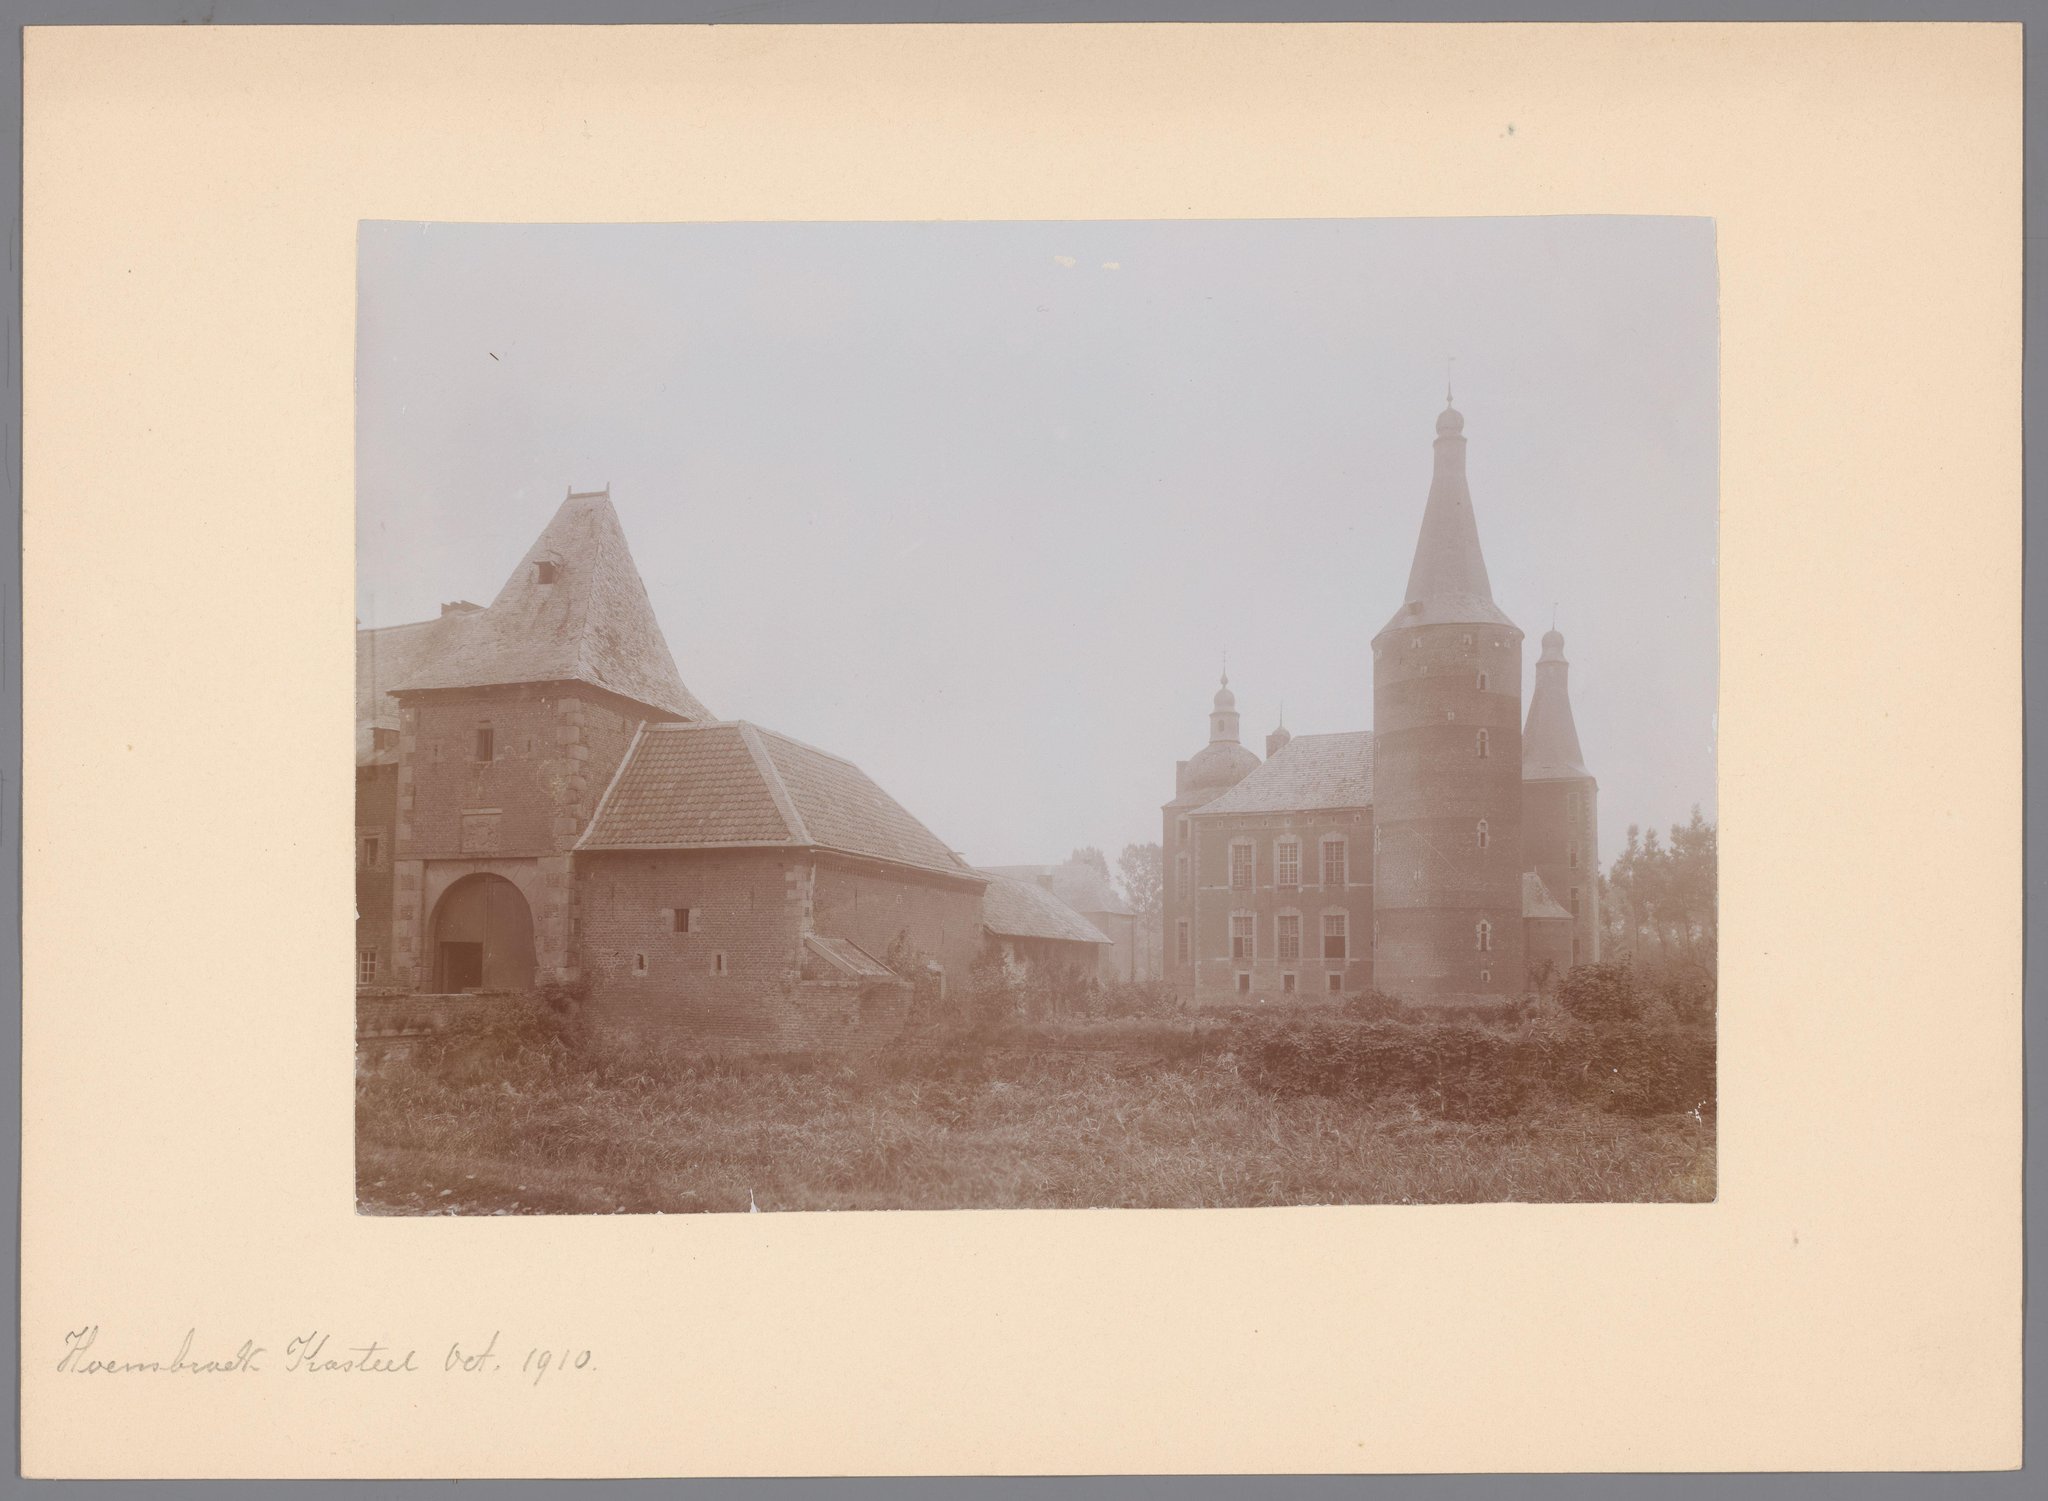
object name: photograph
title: Kasteel Hoensbroek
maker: anoniem (monumentenzorg)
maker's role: fotograaf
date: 1910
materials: cardboard, photographic support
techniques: collodion silver print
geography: hoensbroek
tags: castle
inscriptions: annotation: ‘Hoensbroek kasteel oct. 1910’